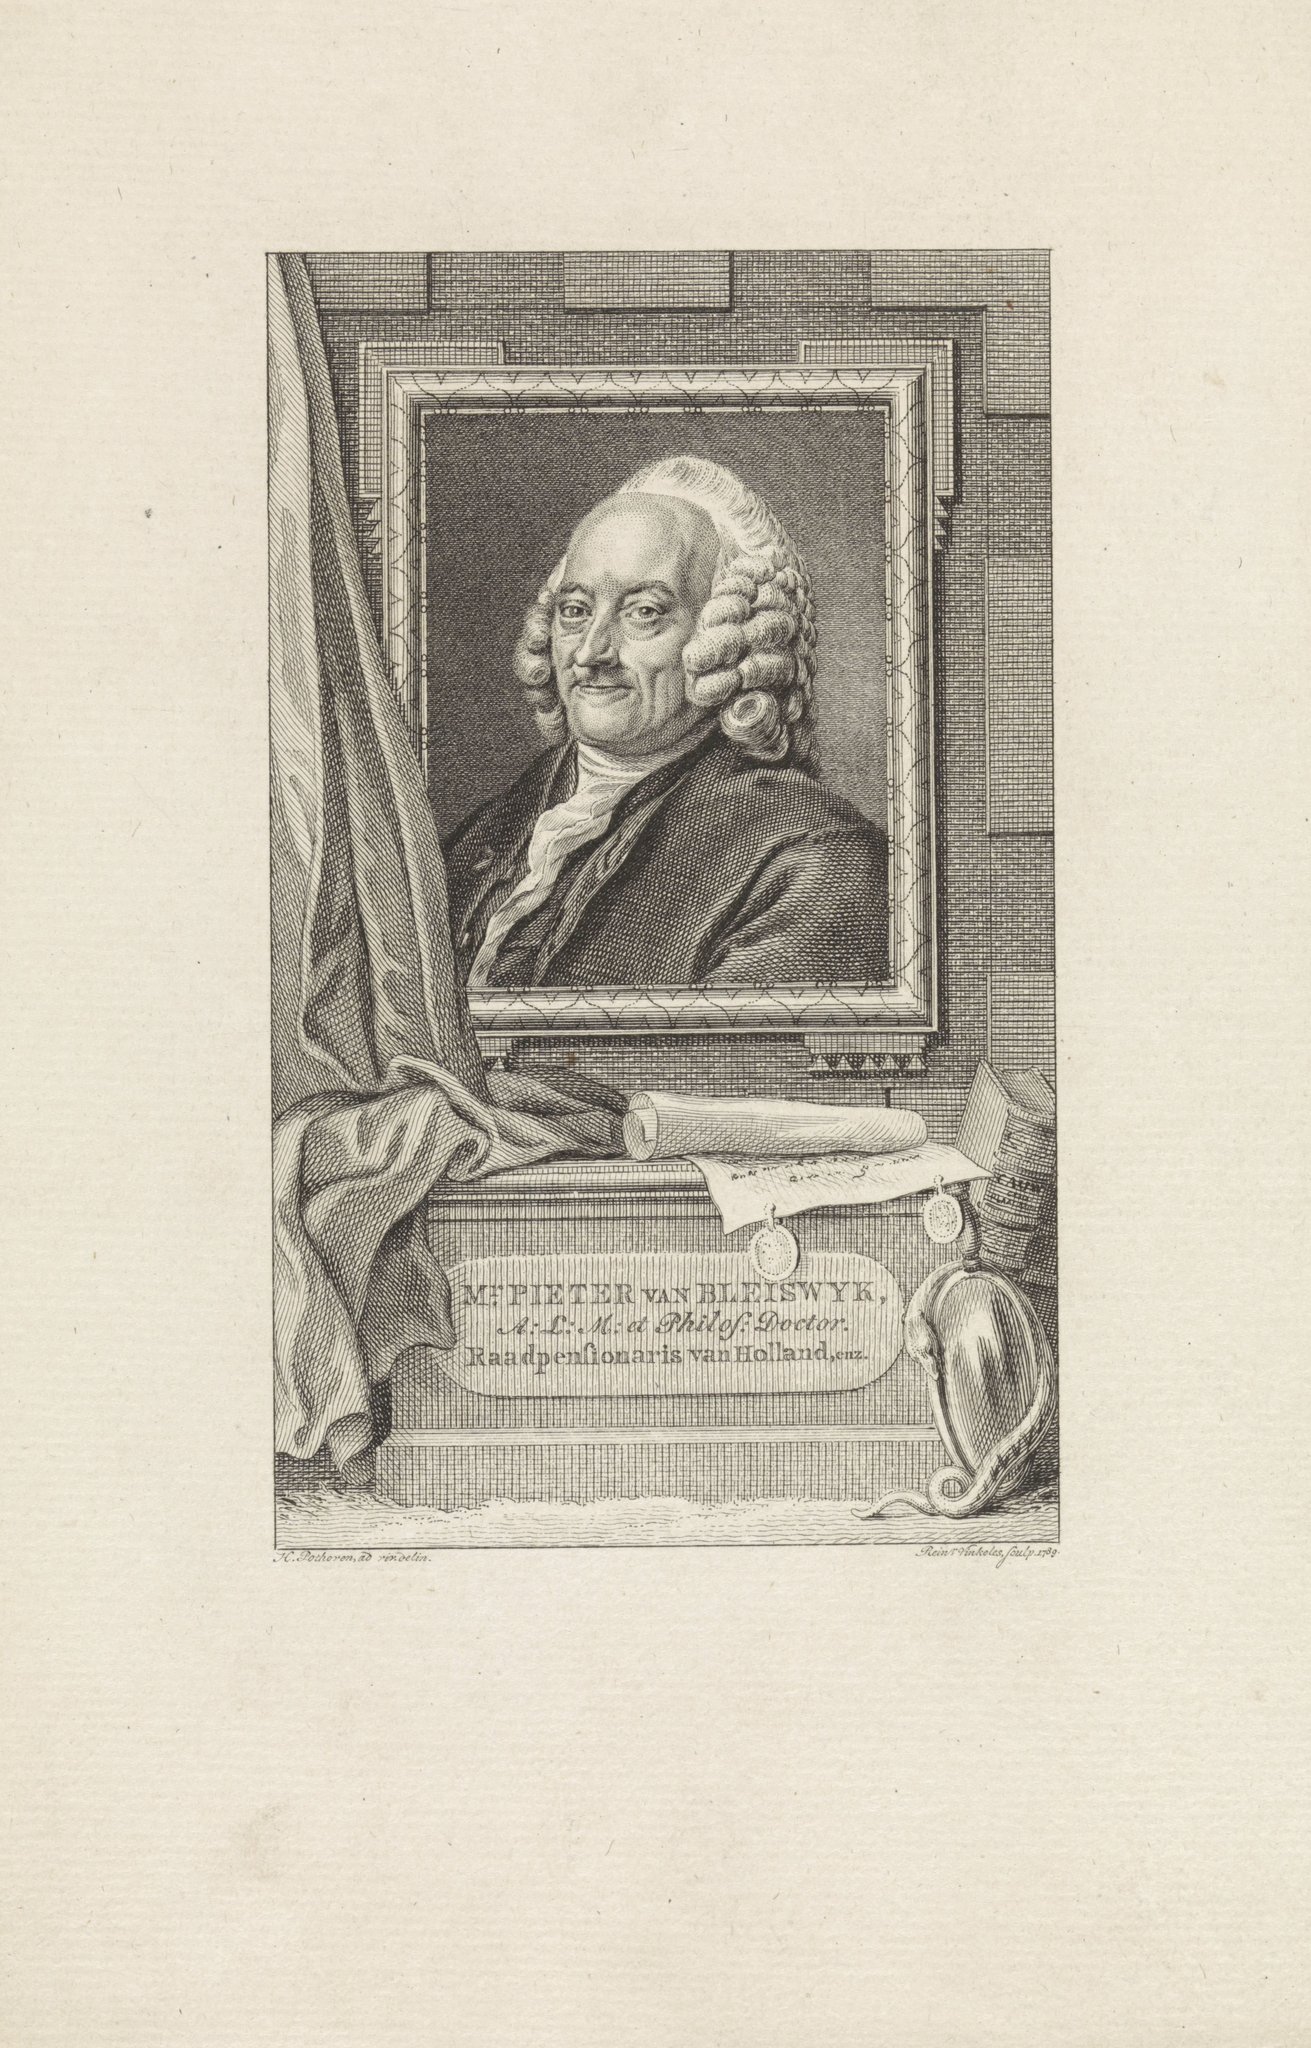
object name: print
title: Portret van Pieter van Bleiswijk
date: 1789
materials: paper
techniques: engraving, etching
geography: amsterdam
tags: delft, the hague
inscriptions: collector's mark: Lugt 2228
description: Prent gebruikt in: Wagenaar, Jan. Vaderlandsche historie, vervattende de geschiedenissen der Vereenigde Nederlanden ... Twee-en-twintigste [- vier-en-twintigste] deel ... ten onmiddelyken vervolge van Wagenaars Vaderlandsche historie. Amsterdam: Johannes Allart, 1788-1789.